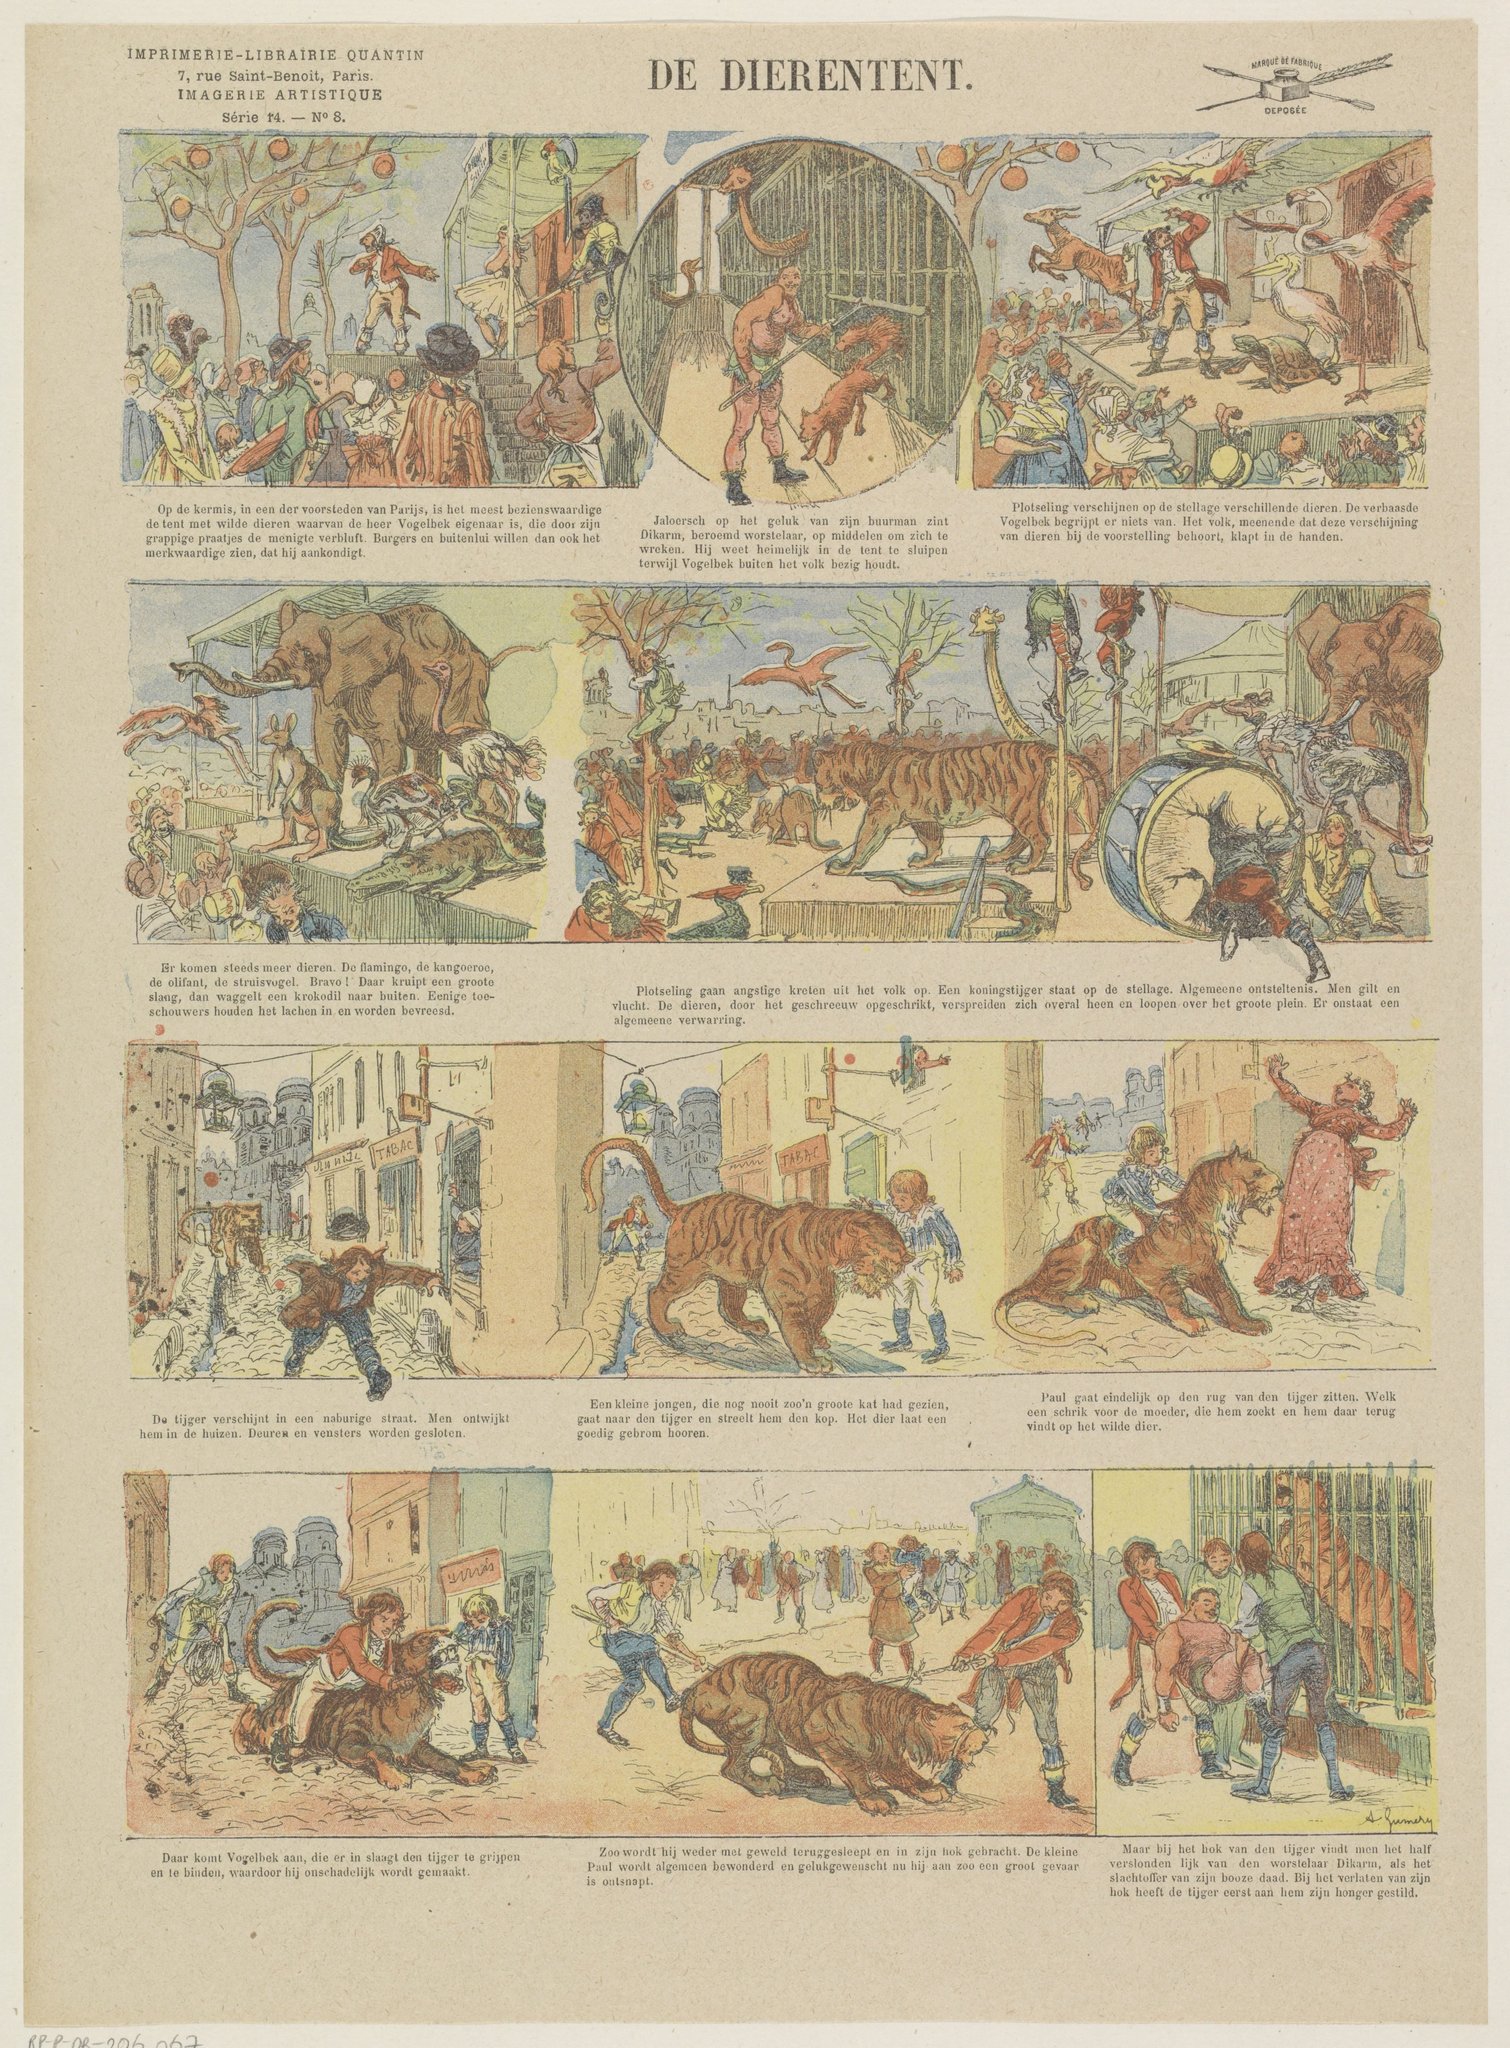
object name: popular print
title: Imagerie Artistique / Série 14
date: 1876-1890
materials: paper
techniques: lithograph, letterpress printing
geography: paris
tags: escape, escape attempts, circus animals, tales and fairy tales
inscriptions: : ‘marque de fabrique / deposée’, collector's mark: Lugt 2760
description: Blad met 4 rijen met voorstellingen van een jaloerse worstelaar die de dieren van de heer Vogelbek stiekem los laat. Onder elke afbeelding een onderschrift. Genummerd linksboven: Série 14. - No. 8.